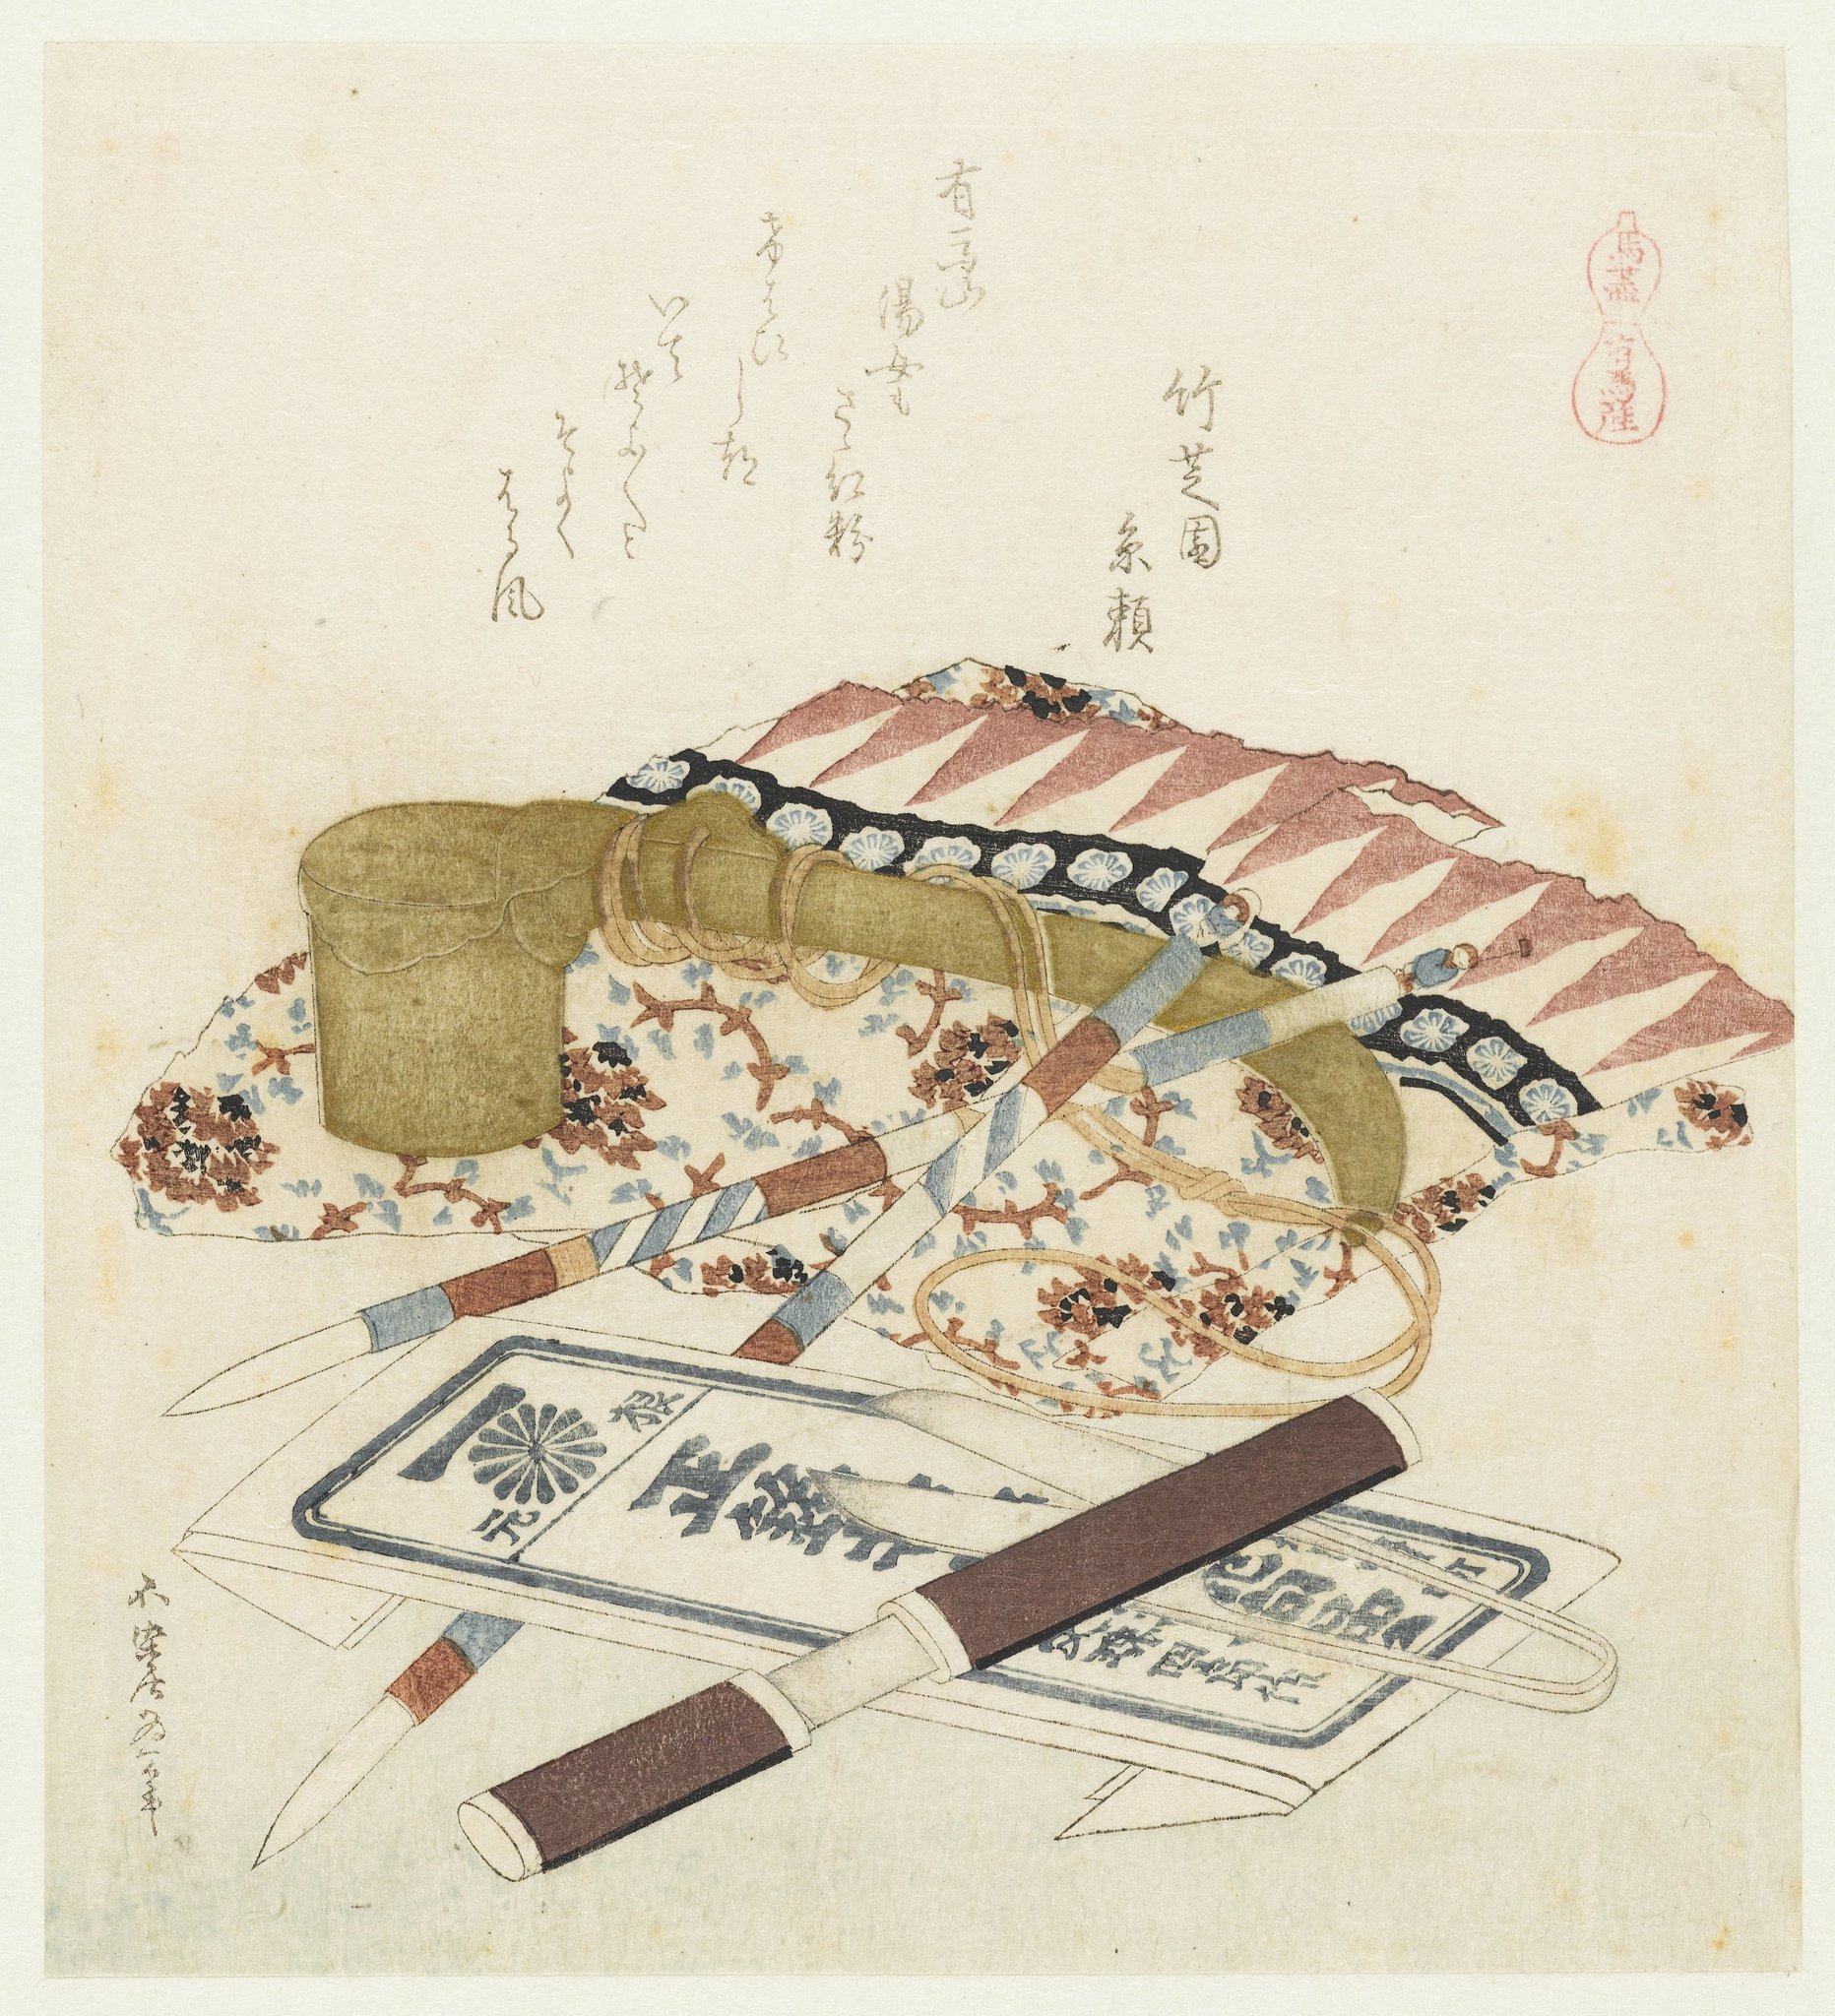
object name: surimono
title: Goederen uit Arima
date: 1822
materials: paper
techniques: blind stamped, woodcut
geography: japan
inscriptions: collector's mark, verso, stamped: Lugt 2228, collector's mark, passe-partout, bottom left, printed: JABdH with a rooster.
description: Een surimono is een luxe uitgevoerde prent waarop beeld met één of meerdere gedichten gecombineerd is. Bij het drukken van een surimono werd vaak gebruik gemaakt van dikker papier, blinddruk en metaal pigmenten, zoals koper- en zilverpoeder. De prenten werden vaak in opdracht van dichters gemaakt en als exclusief geschenk aan vrienden en relaties gegeven.